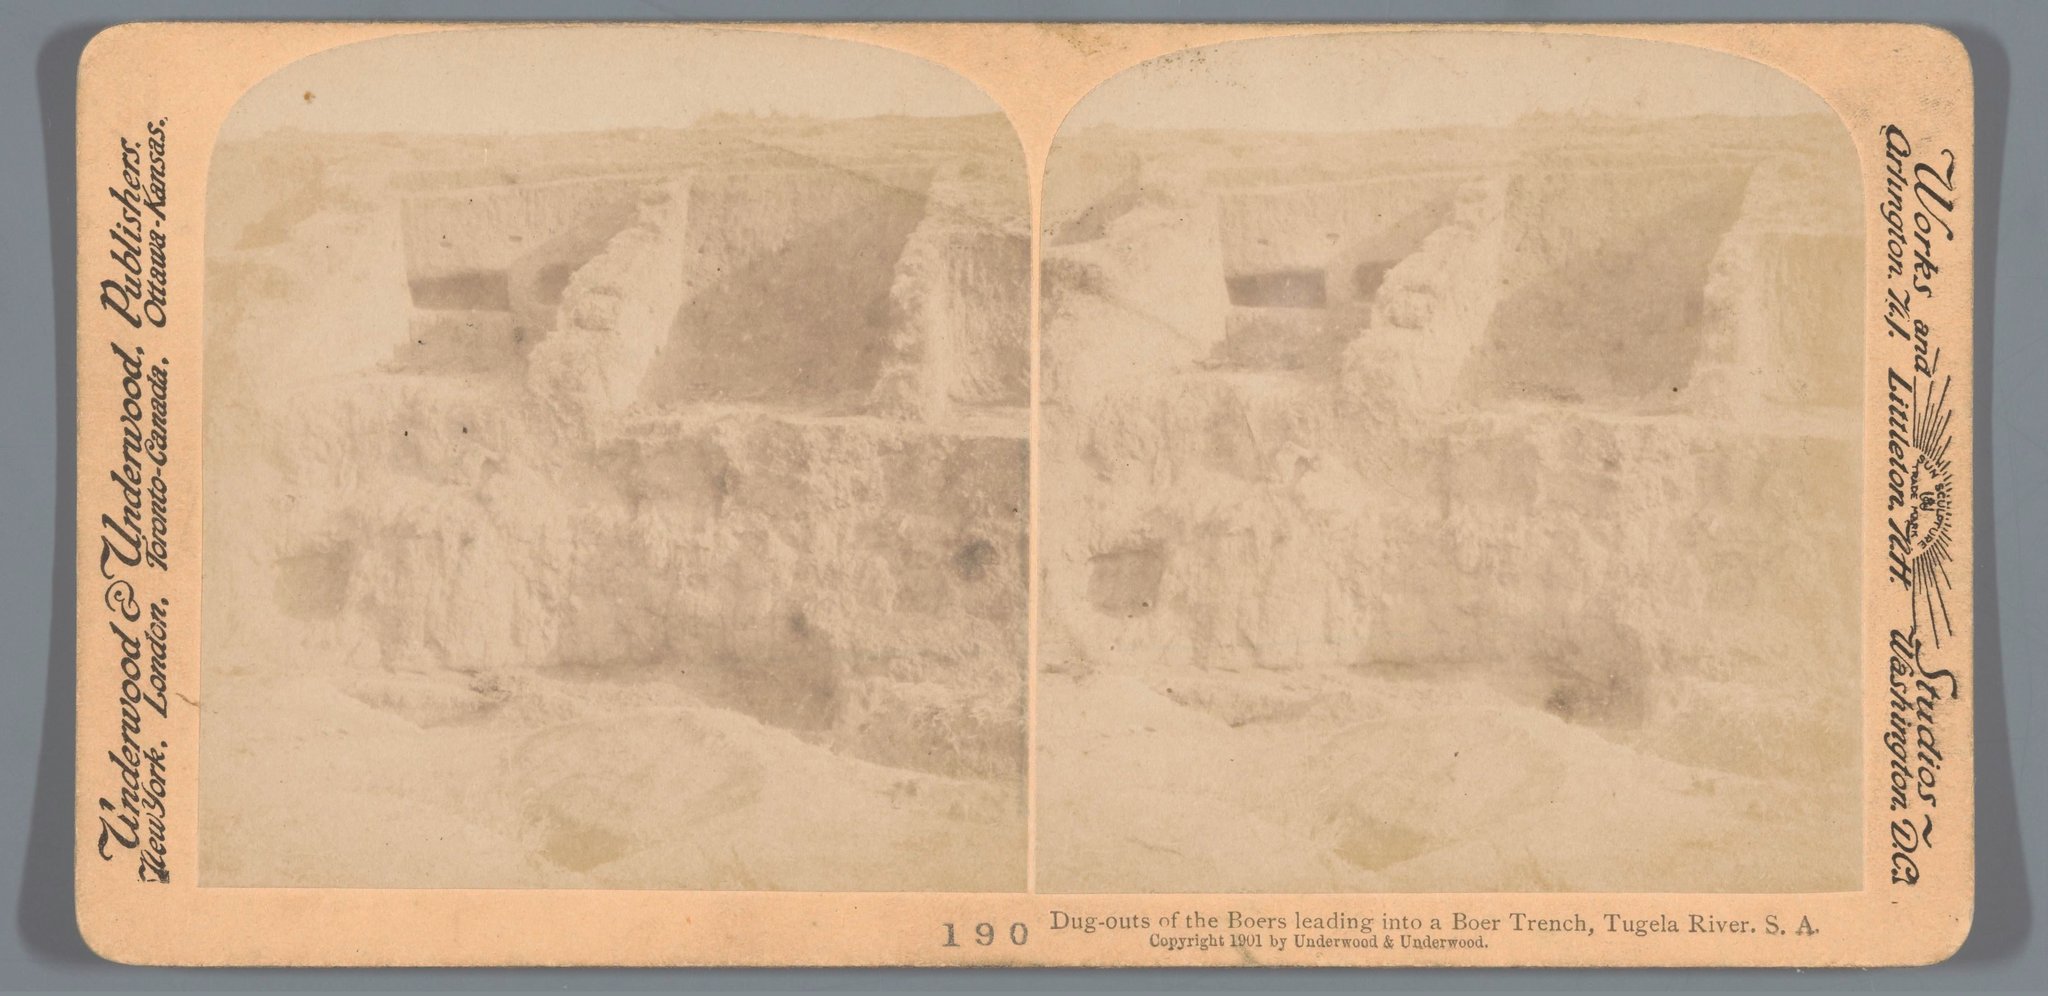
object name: stereograph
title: Loopgraaf van de Boeren uit de Tweede Boerenoorlog in Zuid-Afrika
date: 1901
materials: cardboard, photographic support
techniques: albumen print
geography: south africa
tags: trenches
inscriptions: number: ‘190’, name: ‘Works and Studios Sun Sculpture trade mark Arlington N.J. Littleton N.H. Washington D.C.’